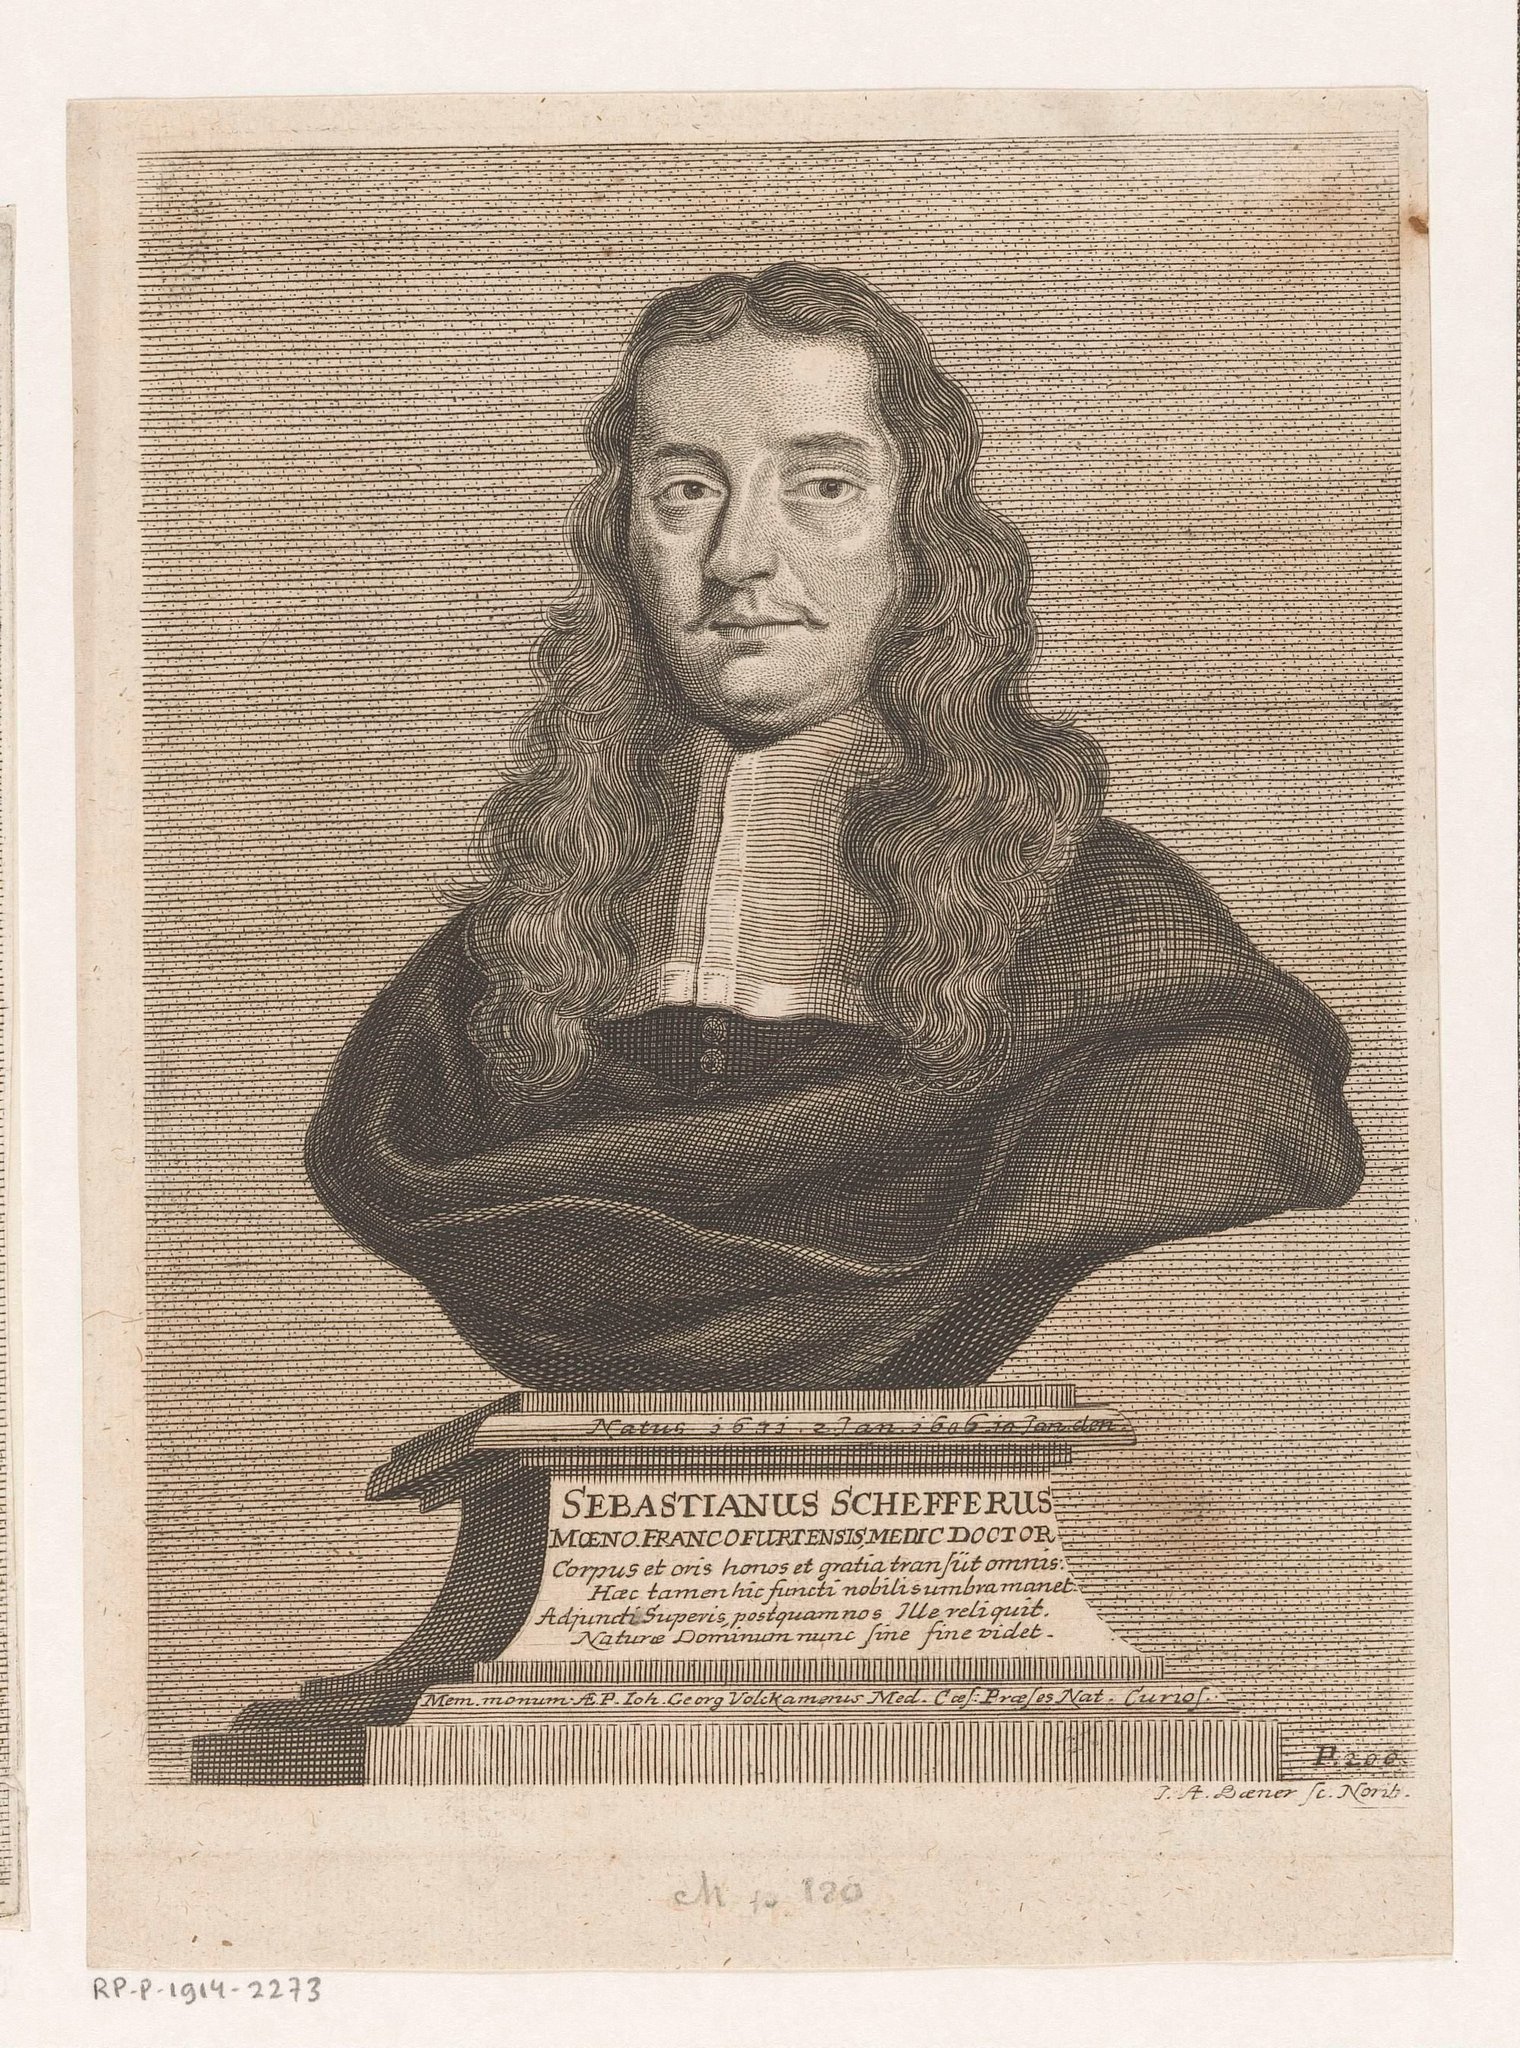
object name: print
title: Portret van Sebastian Scheffer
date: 1686-1720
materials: paper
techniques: engraving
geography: nuremberg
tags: sebastian scheffer, historical persons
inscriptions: collector's mark: Lugt 2228